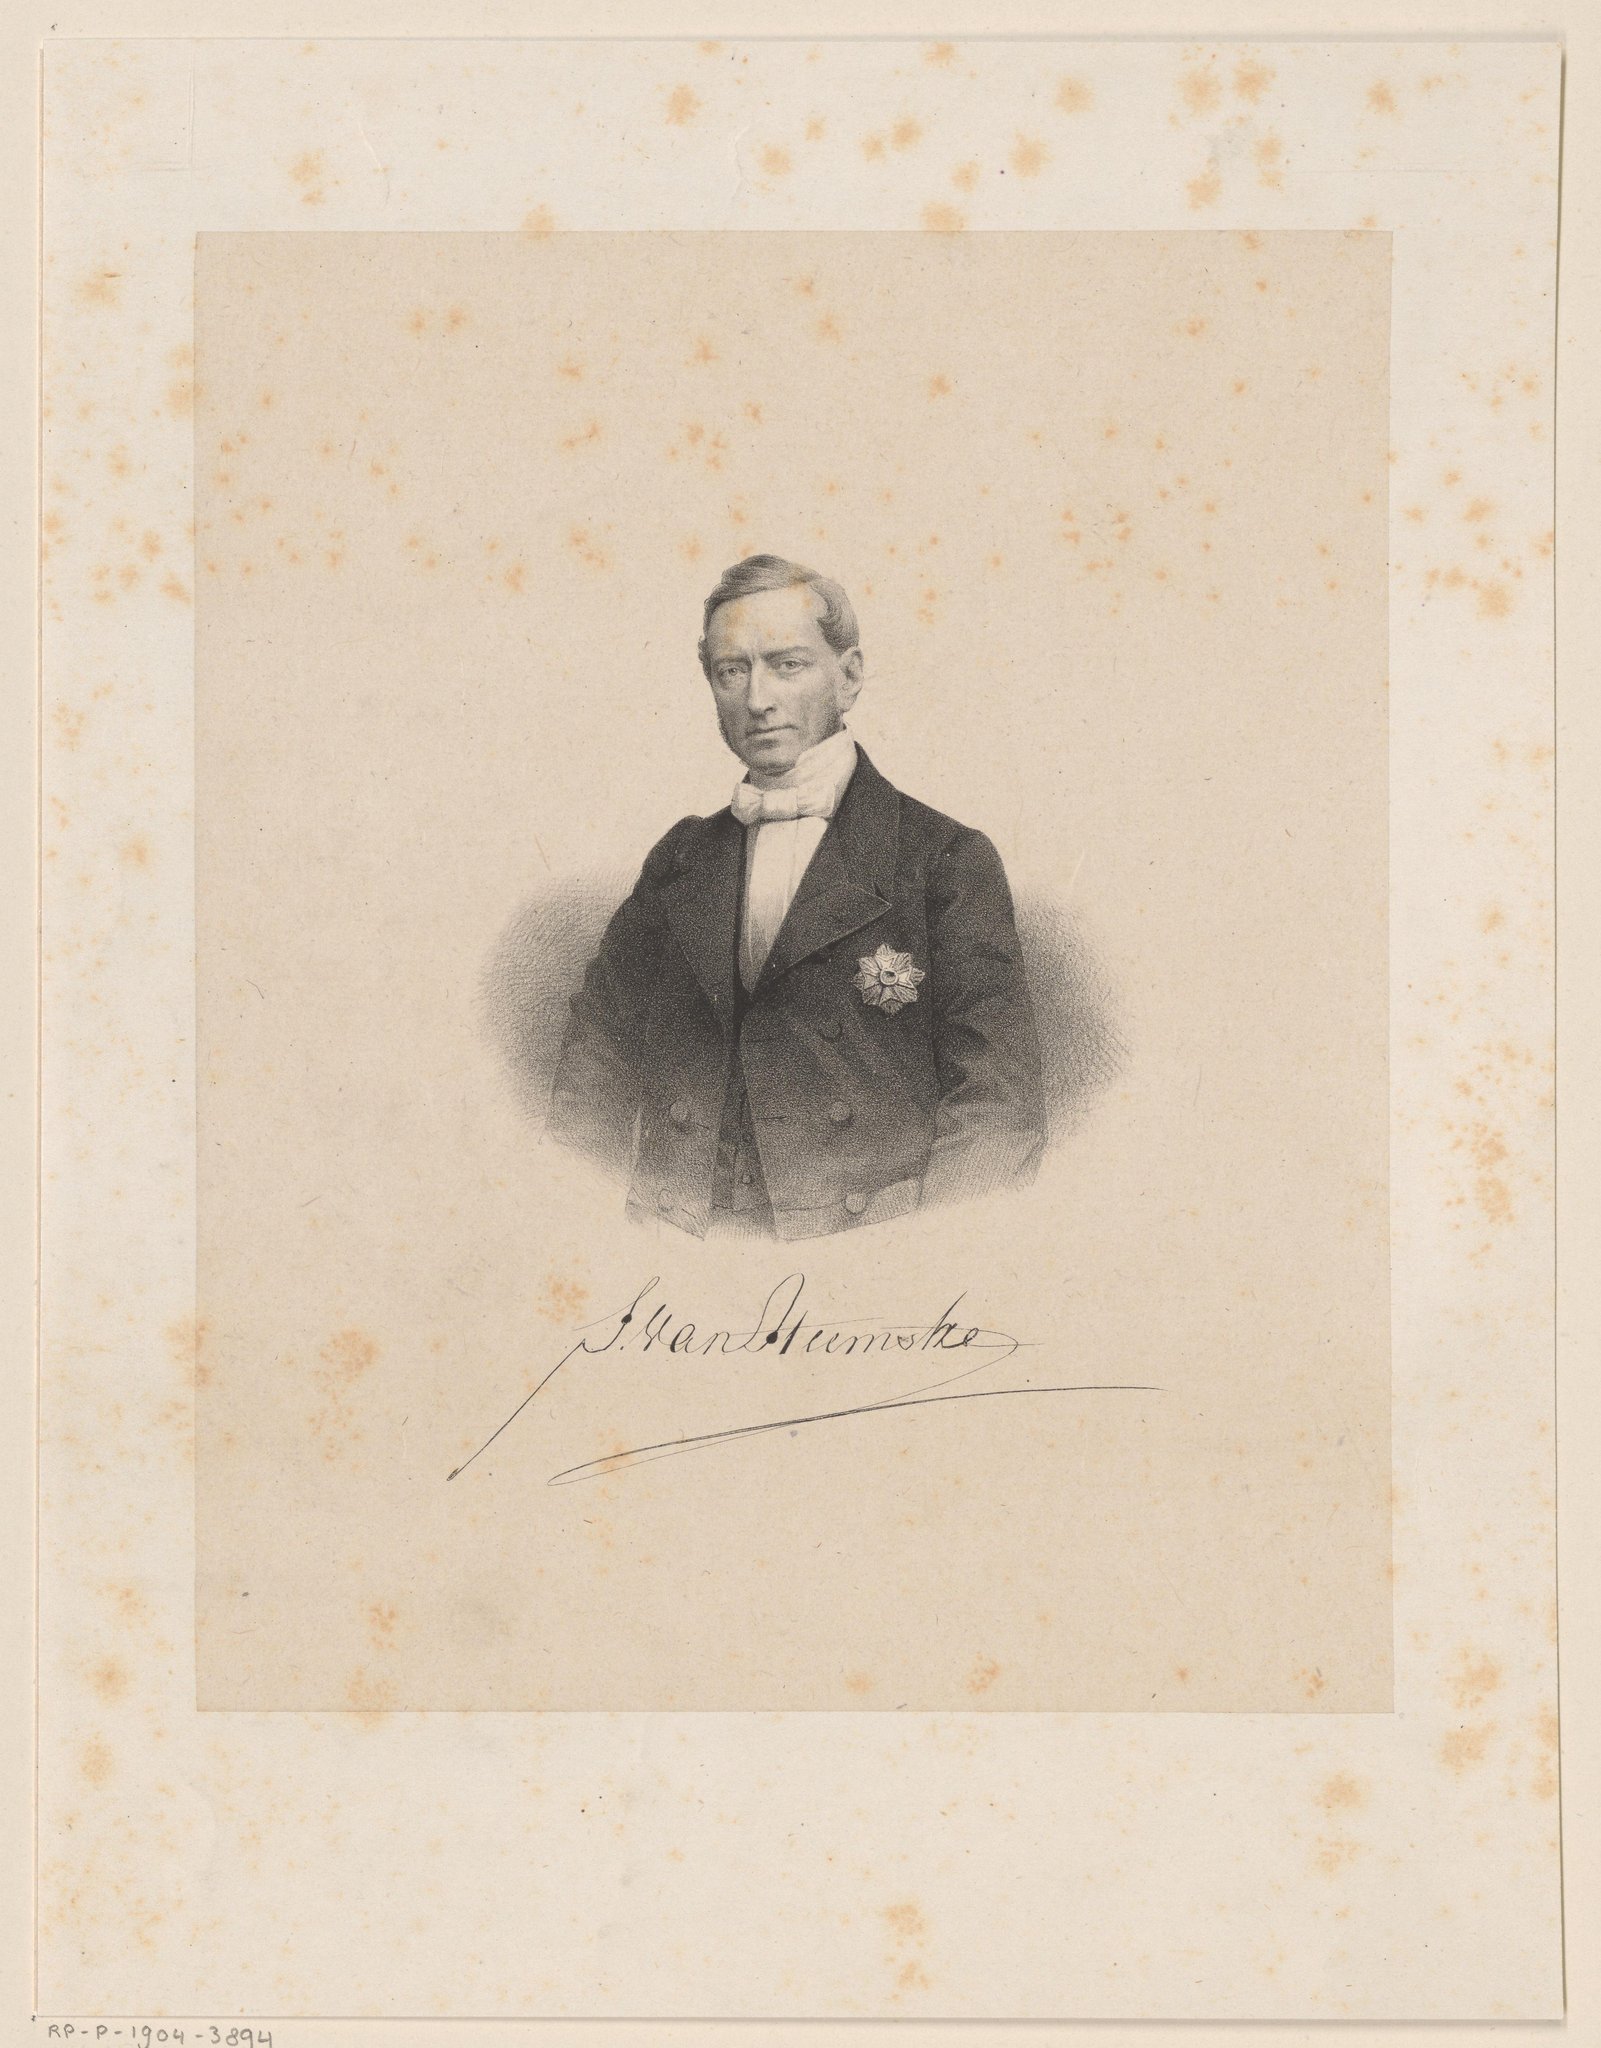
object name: print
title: Portret van Schelto van Heemstra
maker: Anonymous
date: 1850-1874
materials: paper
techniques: lithograph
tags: historical persons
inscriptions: collector's mark: Lugt 2228